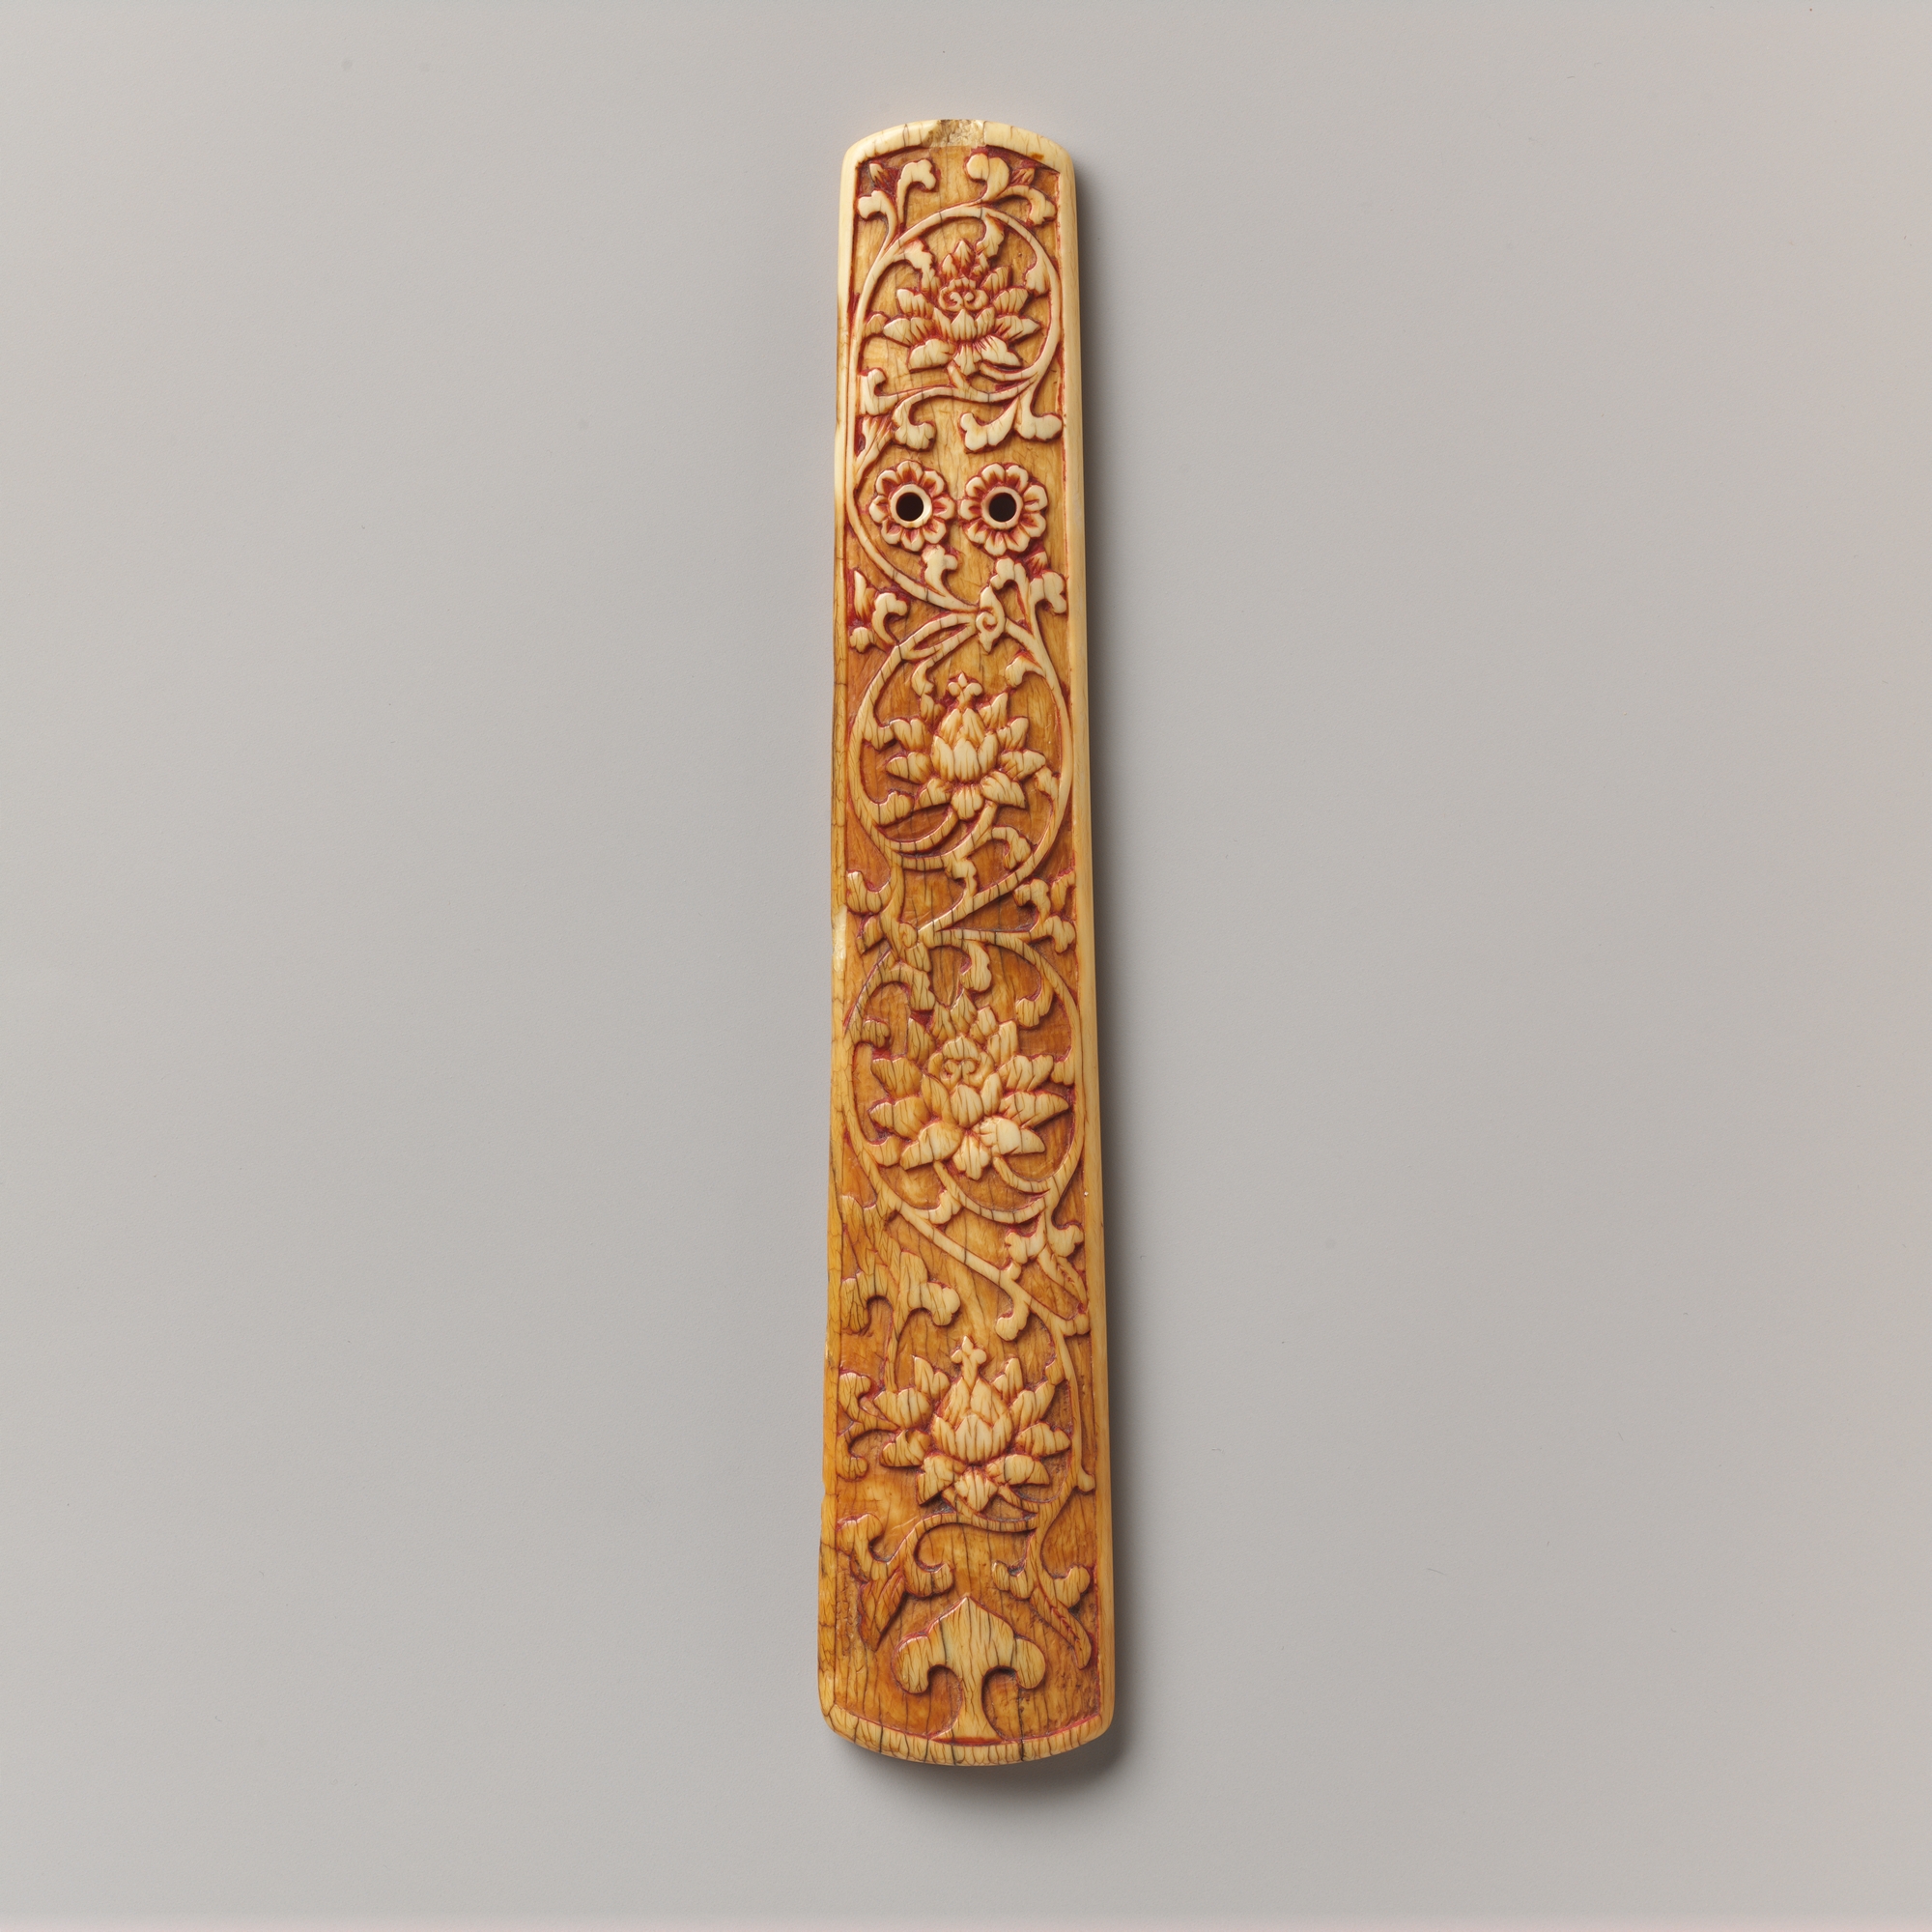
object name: clapper fragment paiban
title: Section of a Clapper (Paiban)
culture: chinese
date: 1401-1433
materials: ivory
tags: lotuses